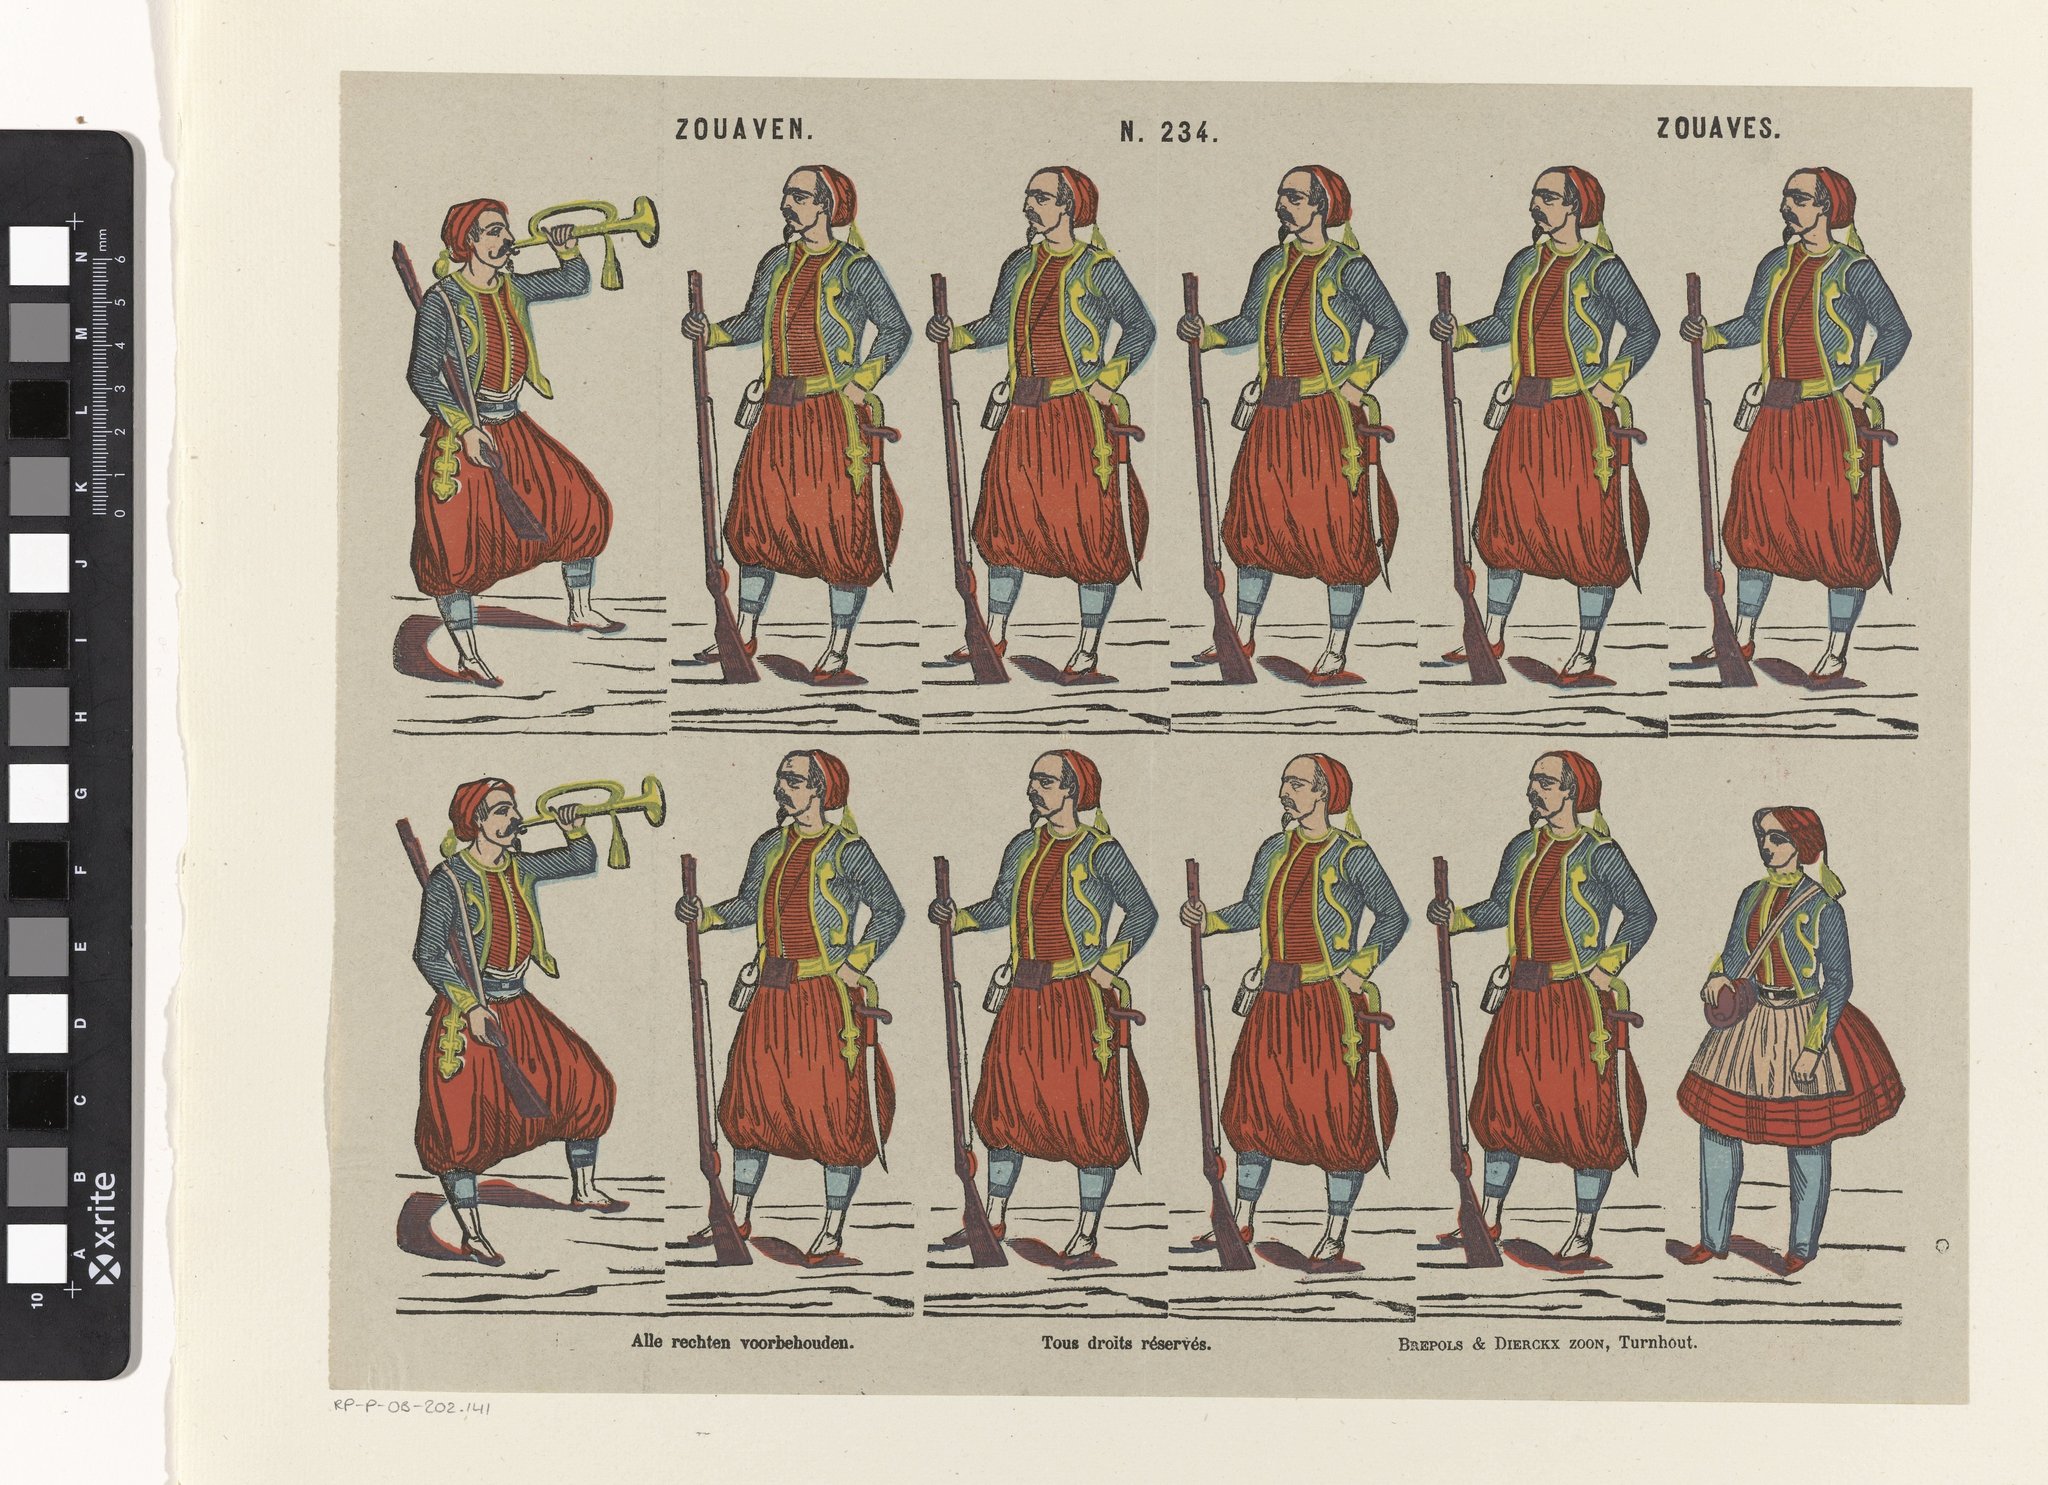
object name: print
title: Zouaven / Zouaves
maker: Anonymous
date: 1833-1911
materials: paper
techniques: lithograph, letterpress printing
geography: turnhout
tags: the soldier; the soldier's life, (military) uniforms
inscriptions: collector's mark: Lugt 2760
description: Blad met 2 horizontale rijen met in totaal 12 voorstellingen van Zoeaven (Franse militairen) met een geweer en een pofbroek. Genummerd midden boven: N. 234.